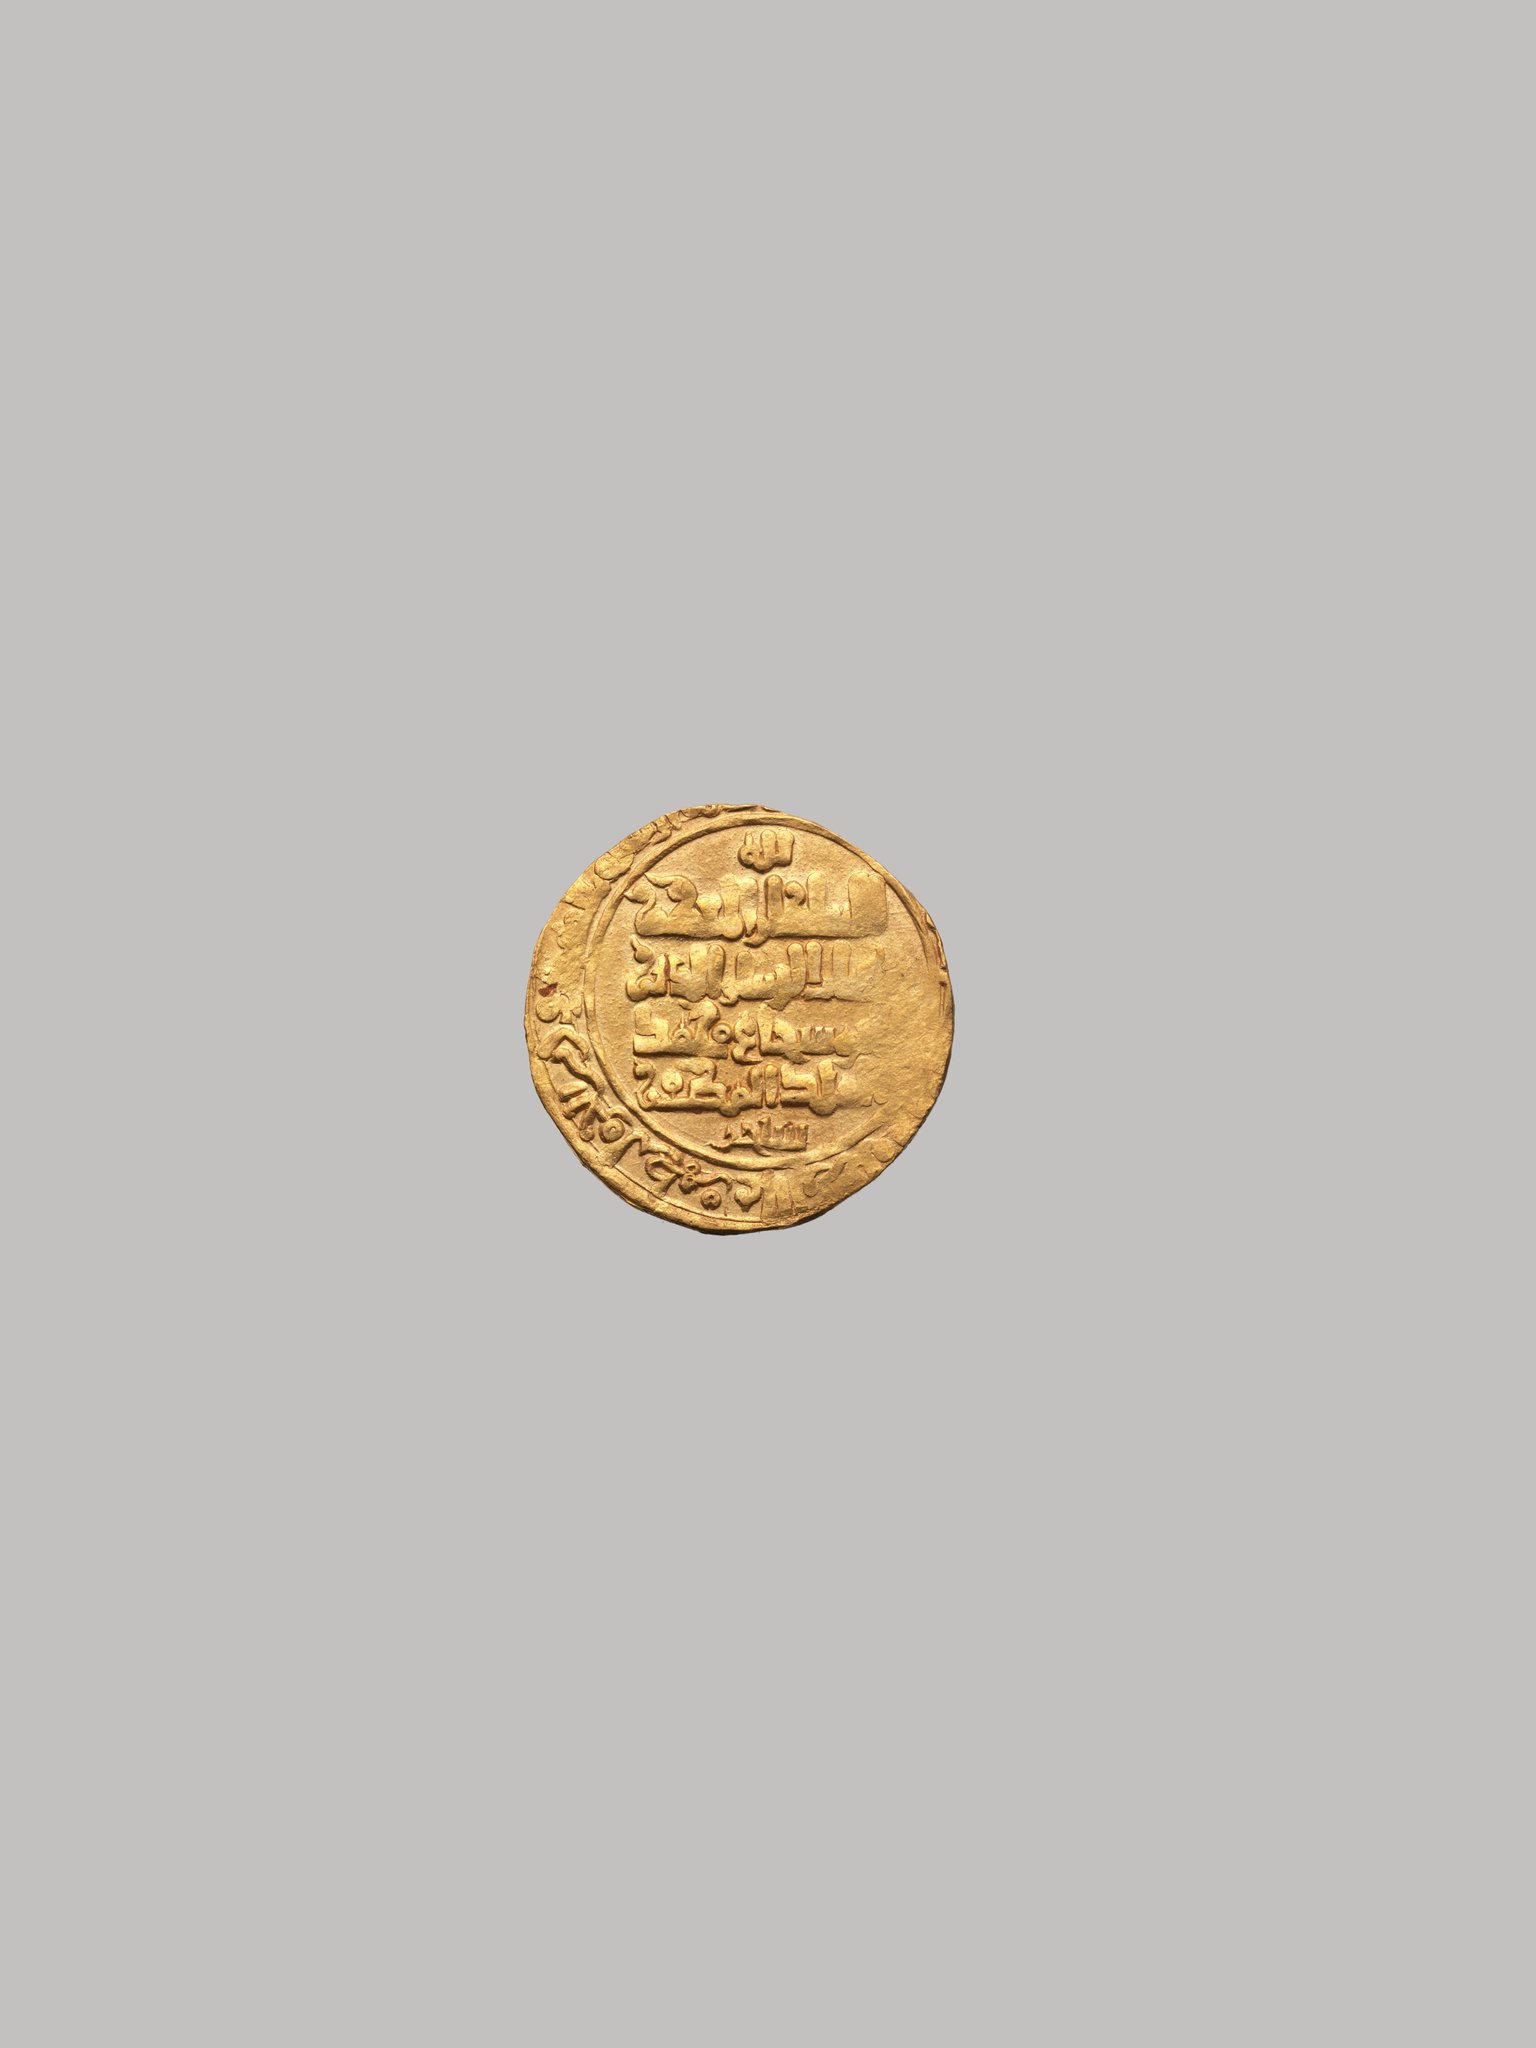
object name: coin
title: Dinar of Sanjar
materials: gold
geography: iran